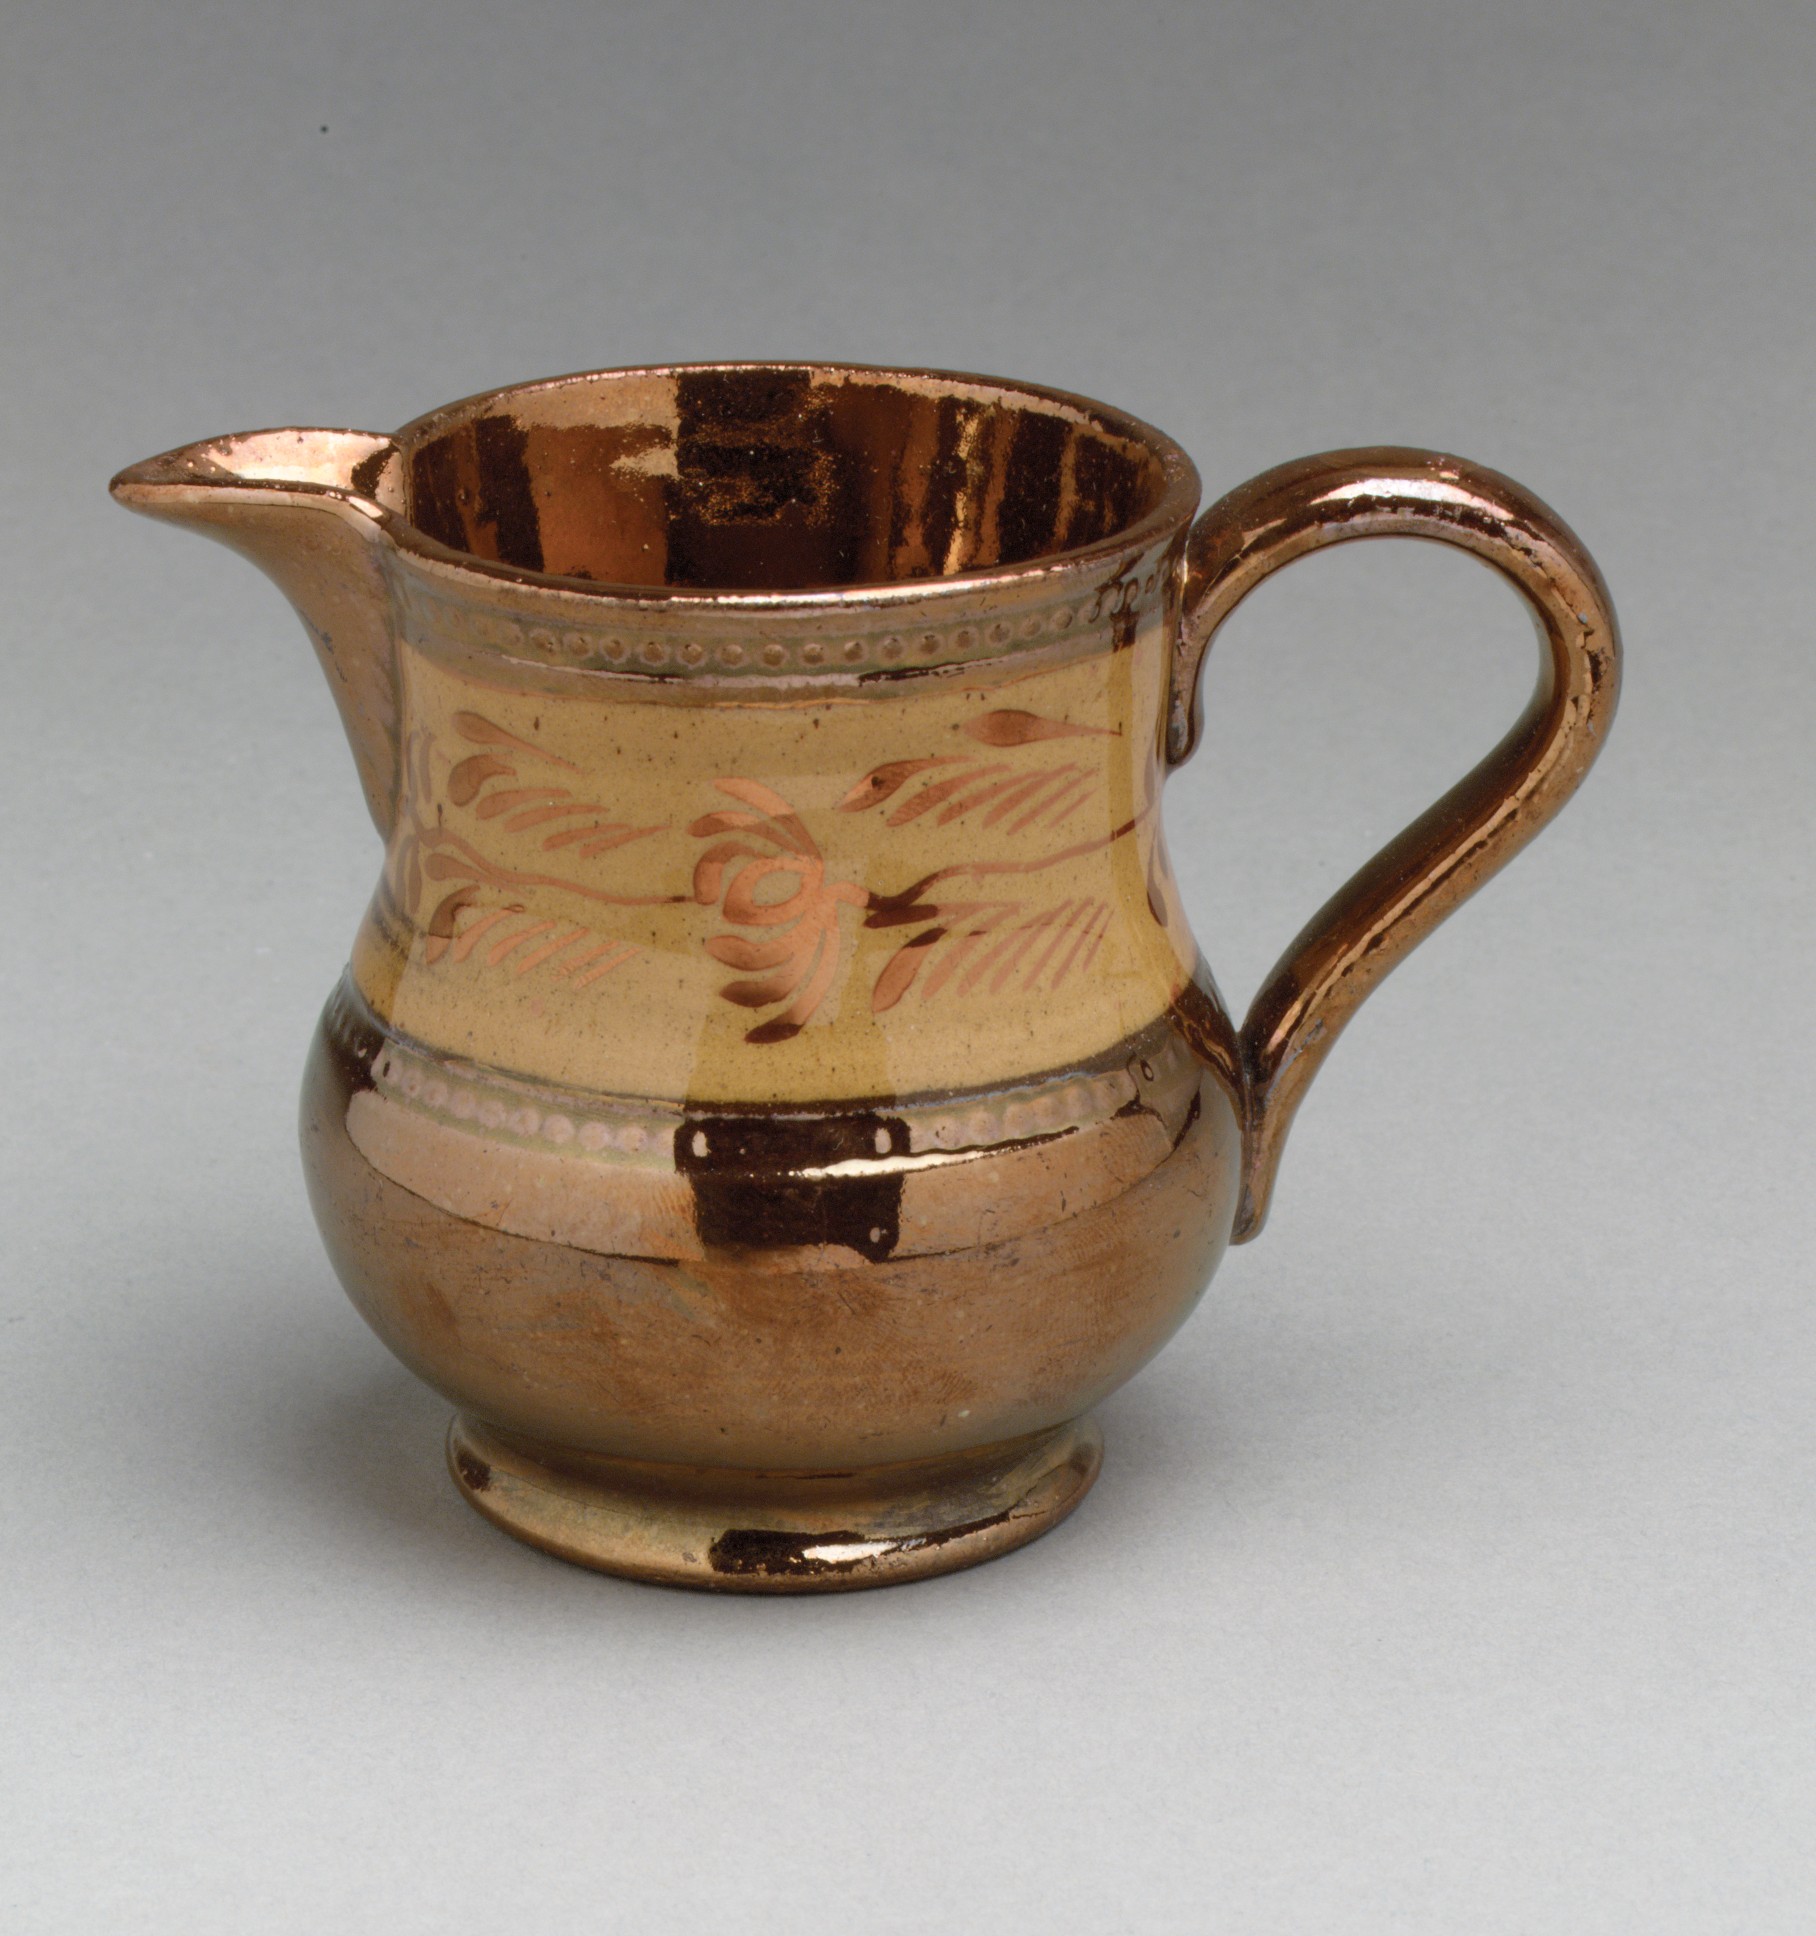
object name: pitcher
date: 1801-1900